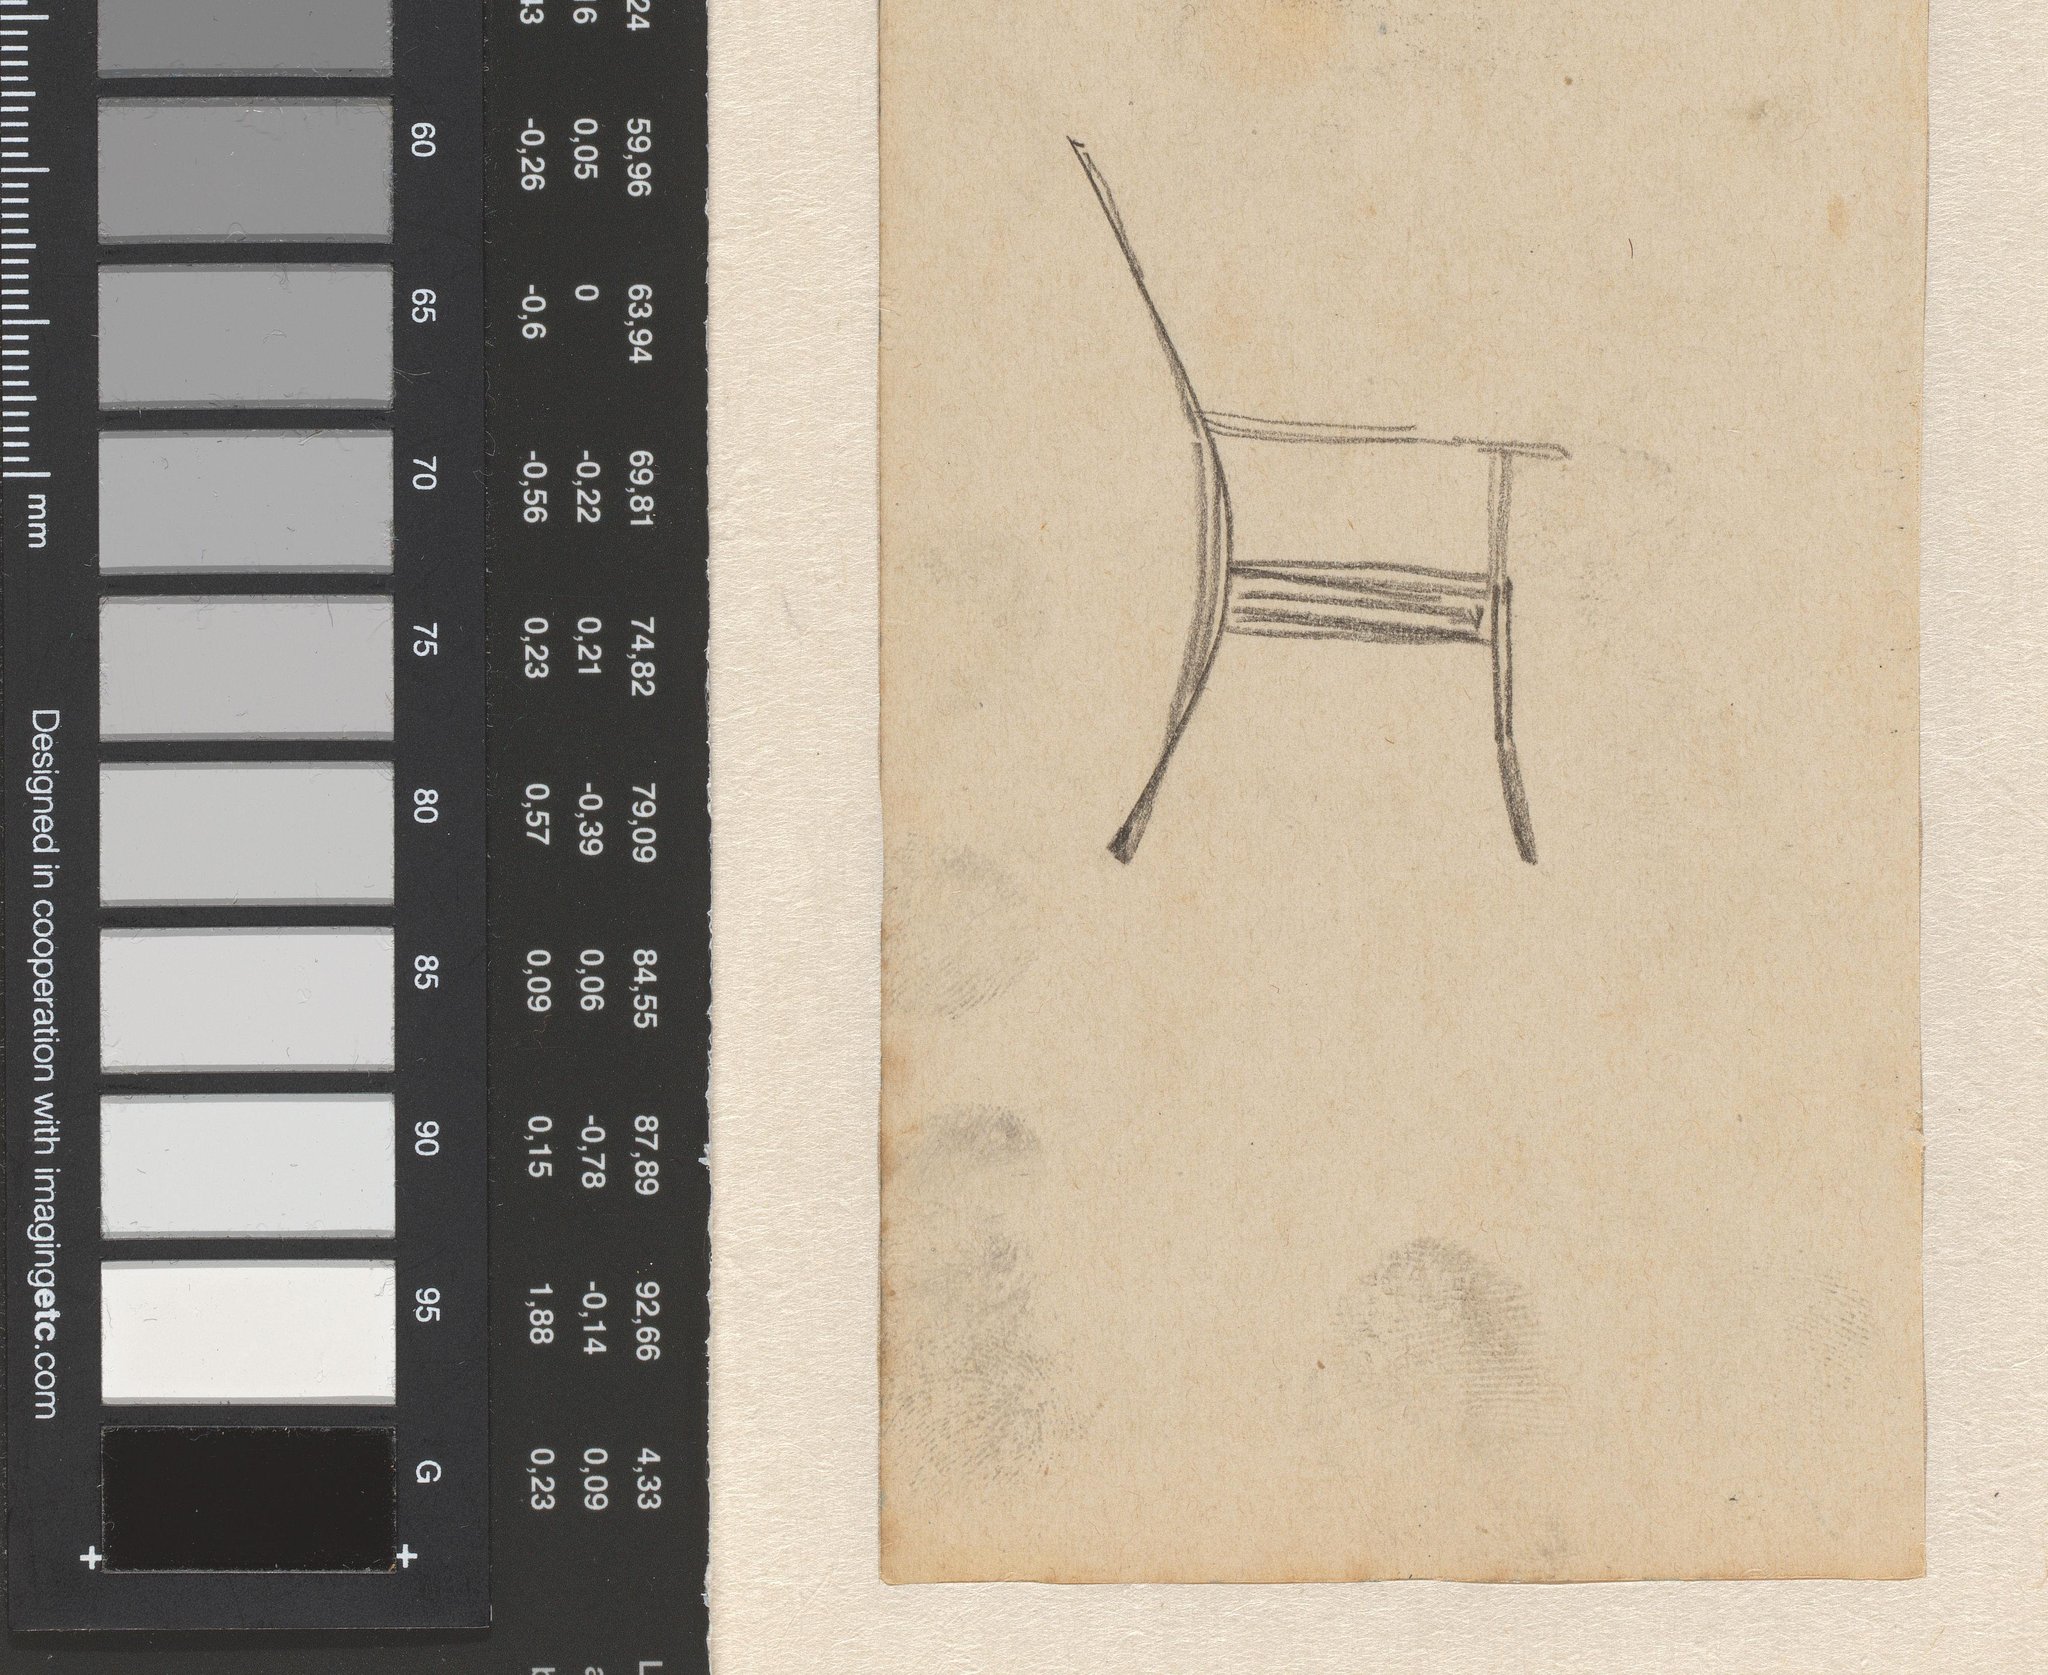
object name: design drawing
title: Twee schetsen voor een stoel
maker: gerrit willem dijsselhof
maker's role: designer, draughtsman, print maker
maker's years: 1866-1924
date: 1881-1924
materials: chalk, paper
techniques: drawing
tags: chair